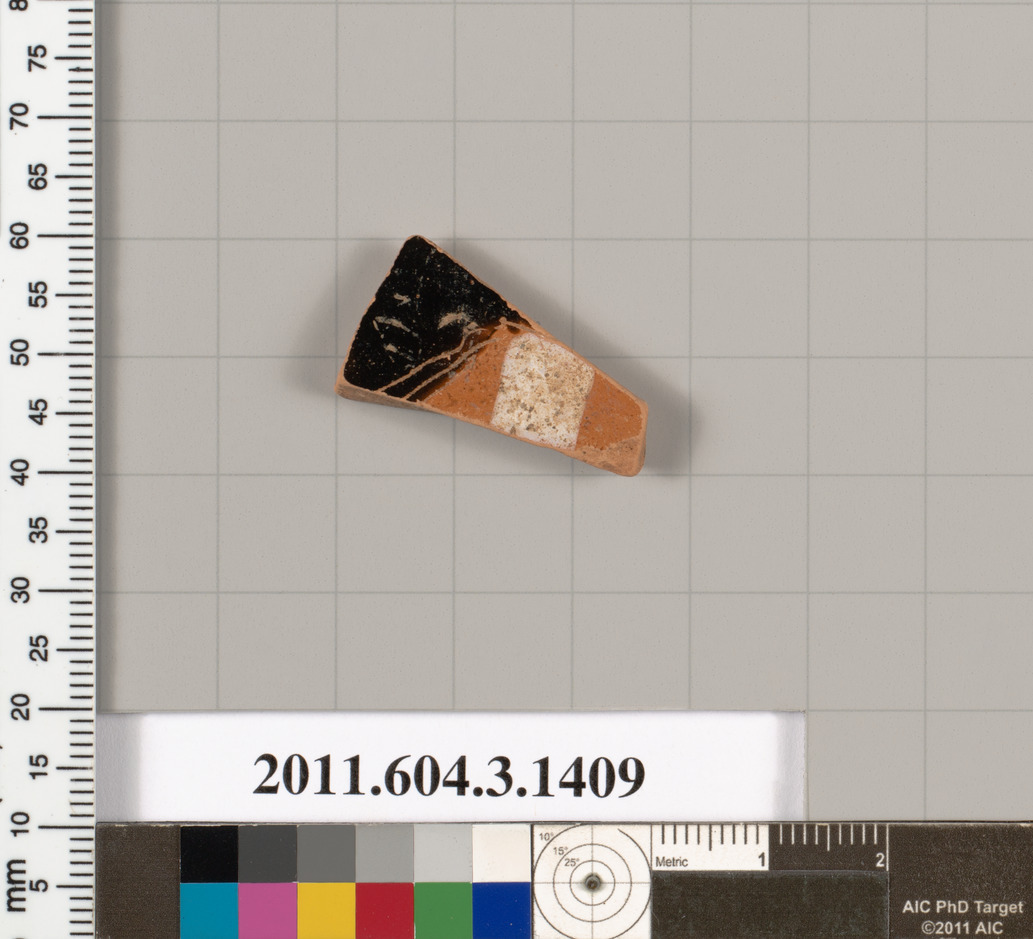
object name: skyphos fragment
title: Terracotta fragment of a skyphos (deep drinking cup)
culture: greek, attic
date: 534-468 BCE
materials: terracotta